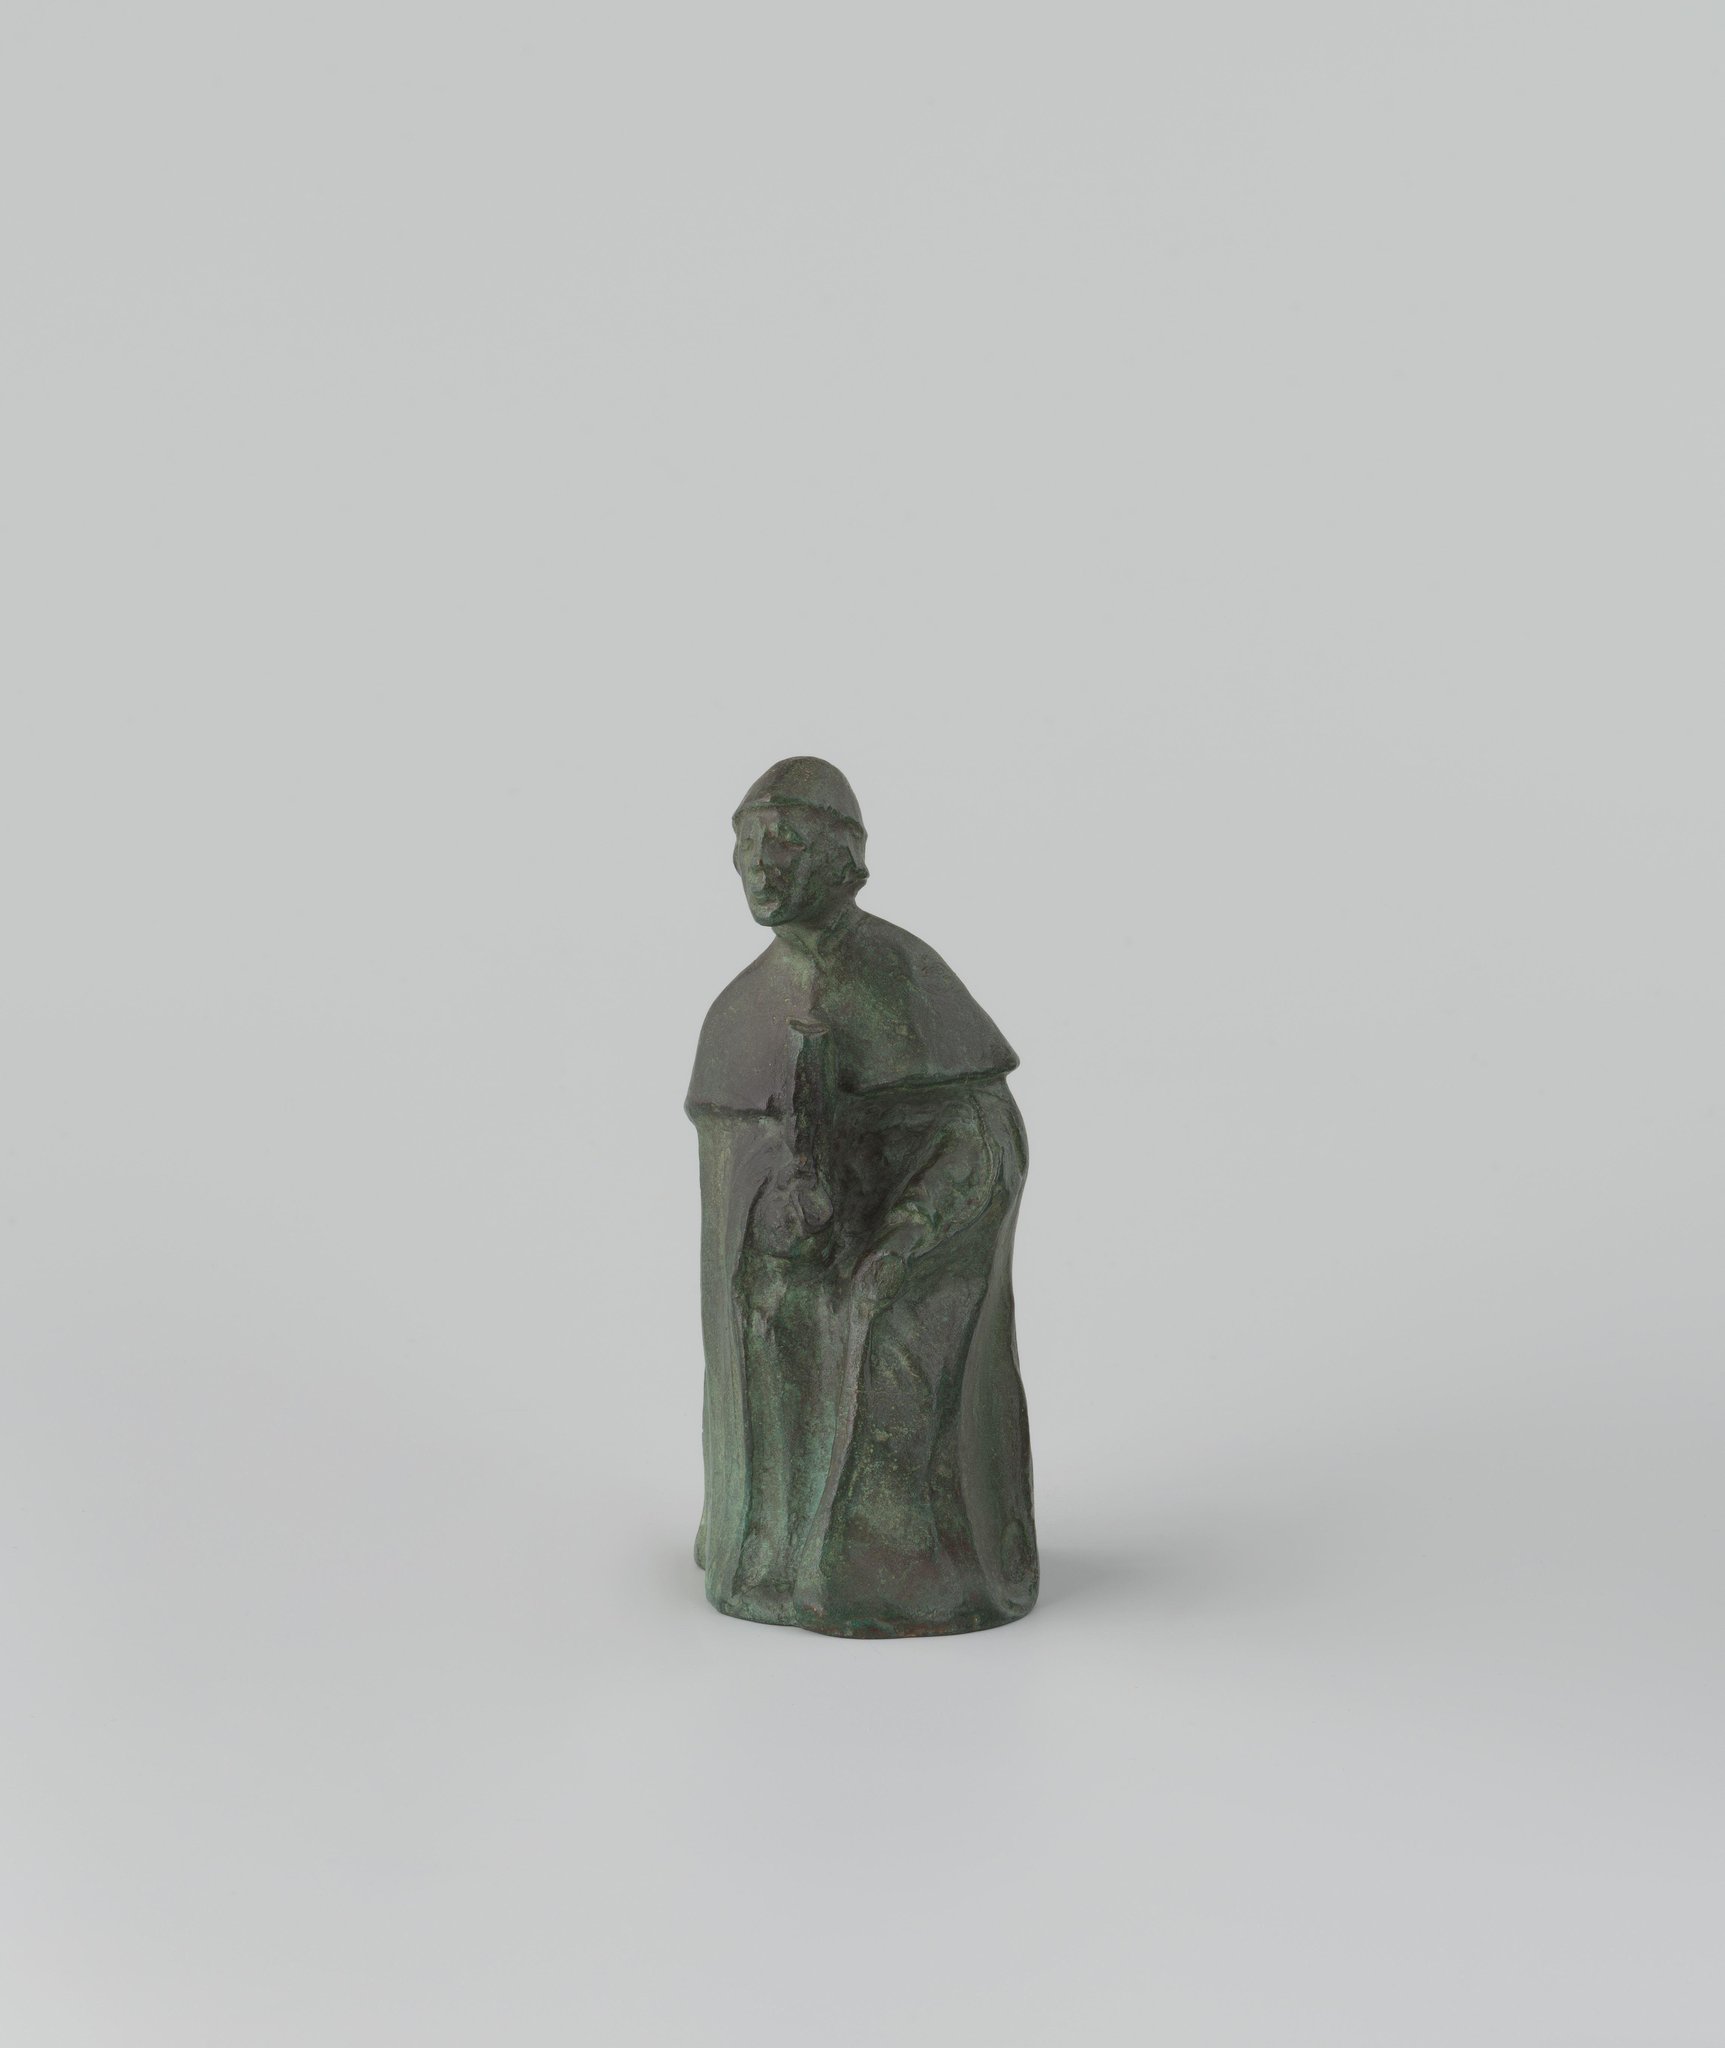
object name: chess piece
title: Paard 2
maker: saar de swart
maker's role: sculptor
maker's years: 1861-1951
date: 1923-1925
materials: bronze, oxide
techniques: casting, lost wax process, patinaed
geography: capri